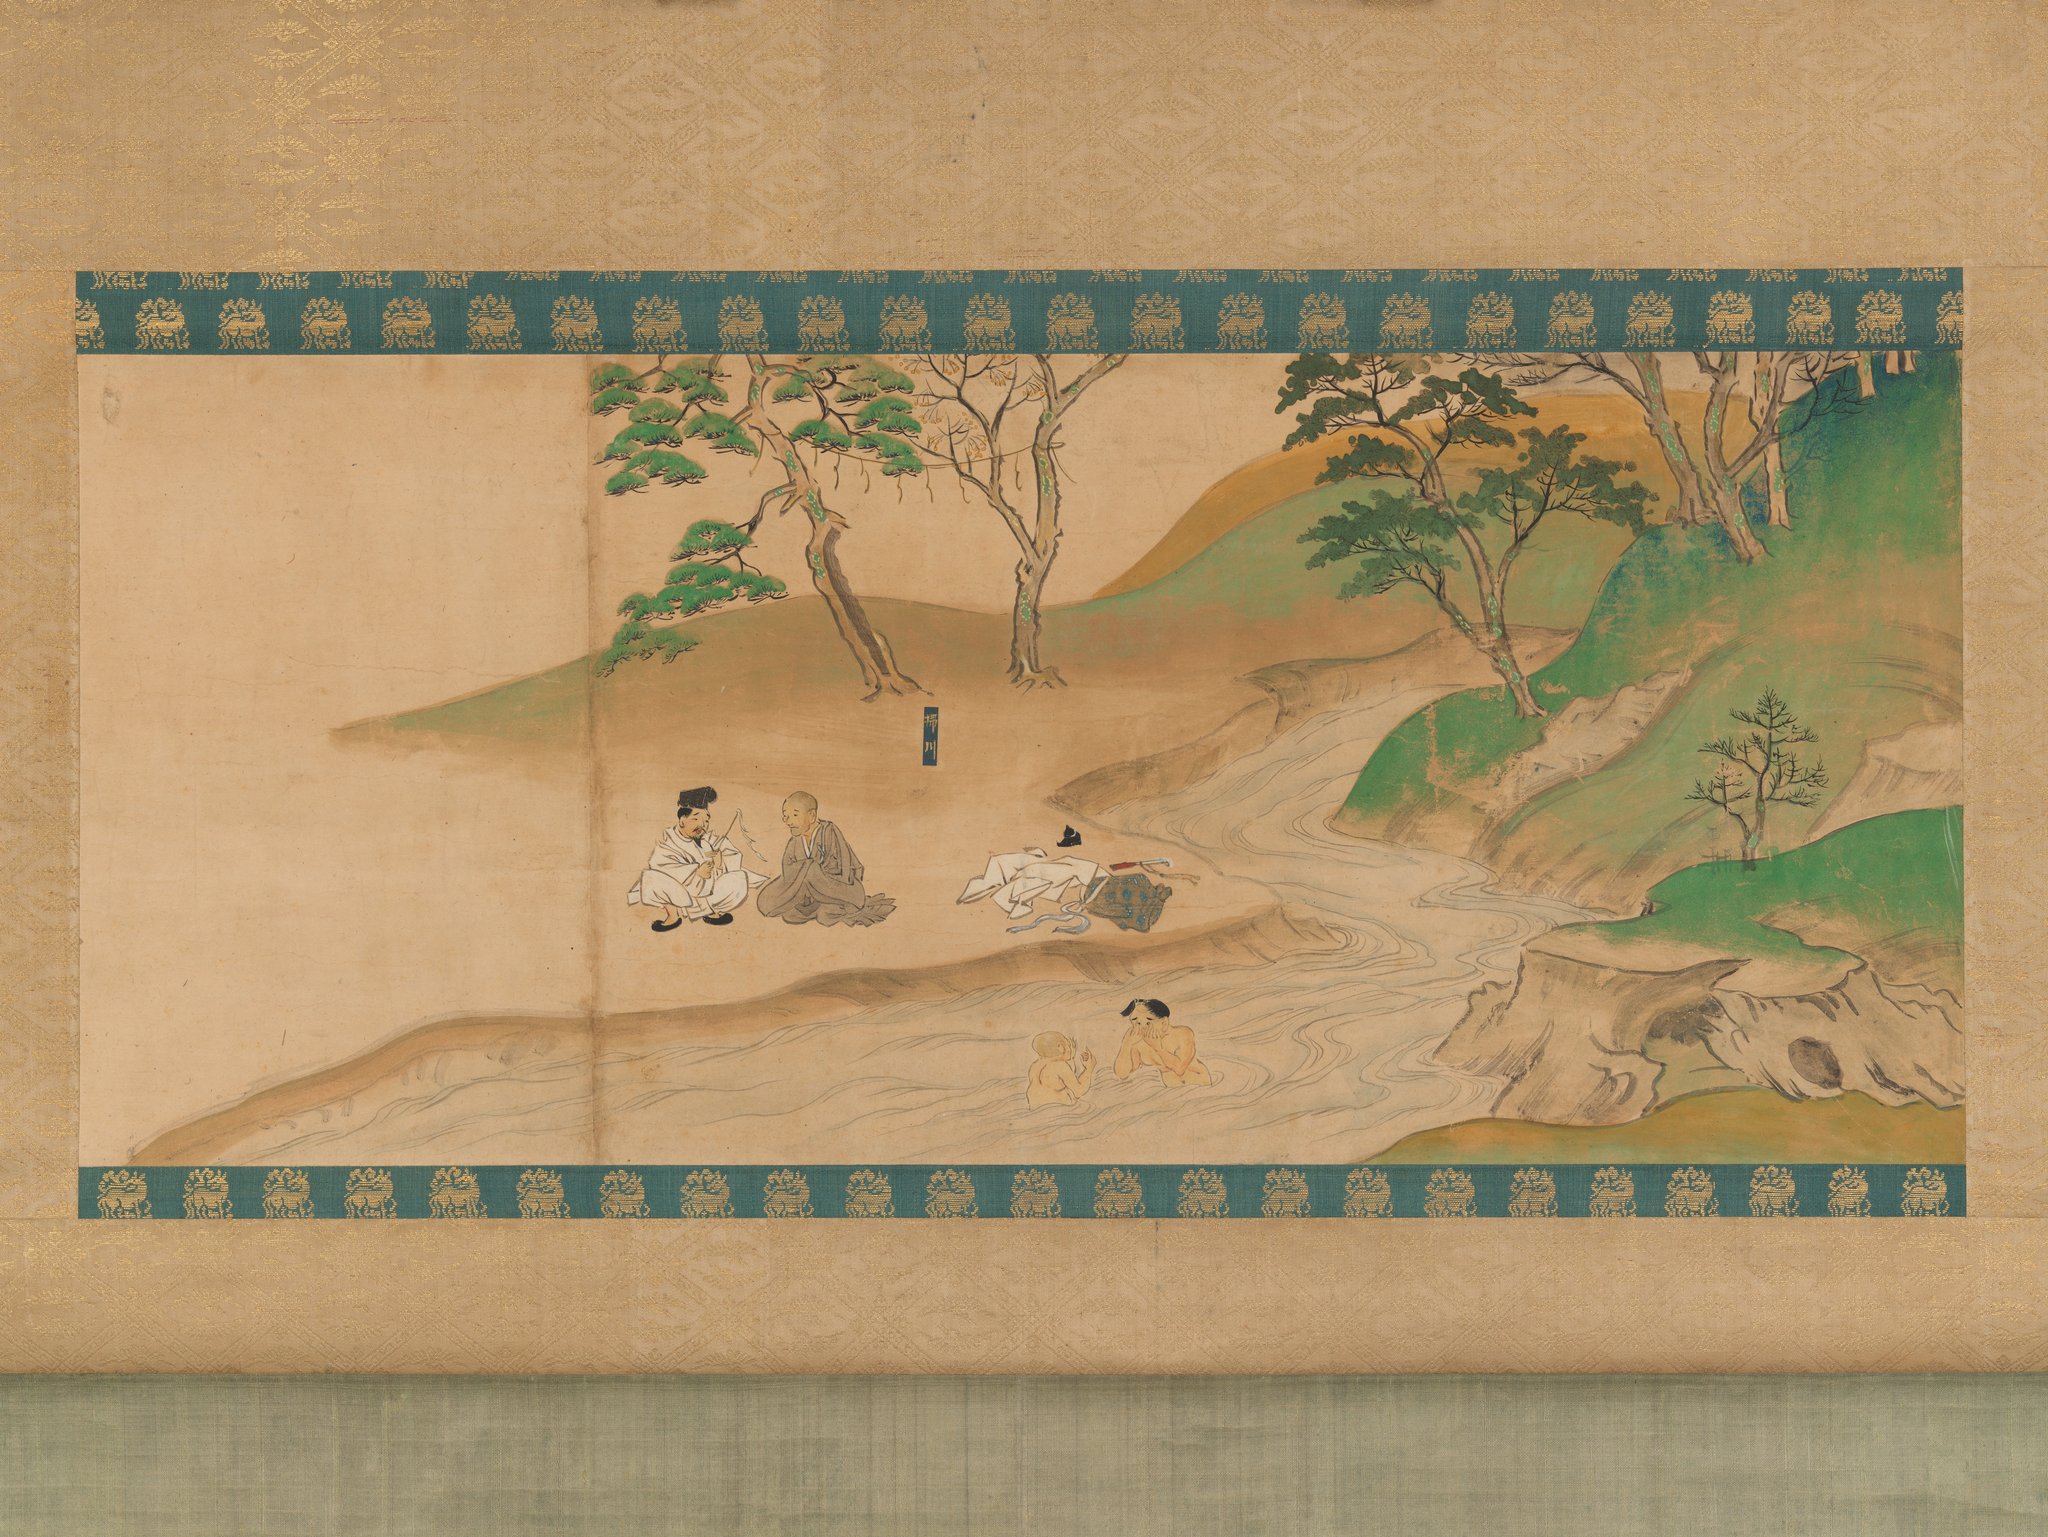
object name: hanging scroll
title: Section of Jin'o-ji Engi Emaki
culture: japanese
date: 1301-1333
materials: ink, paper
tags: men,monks,streams